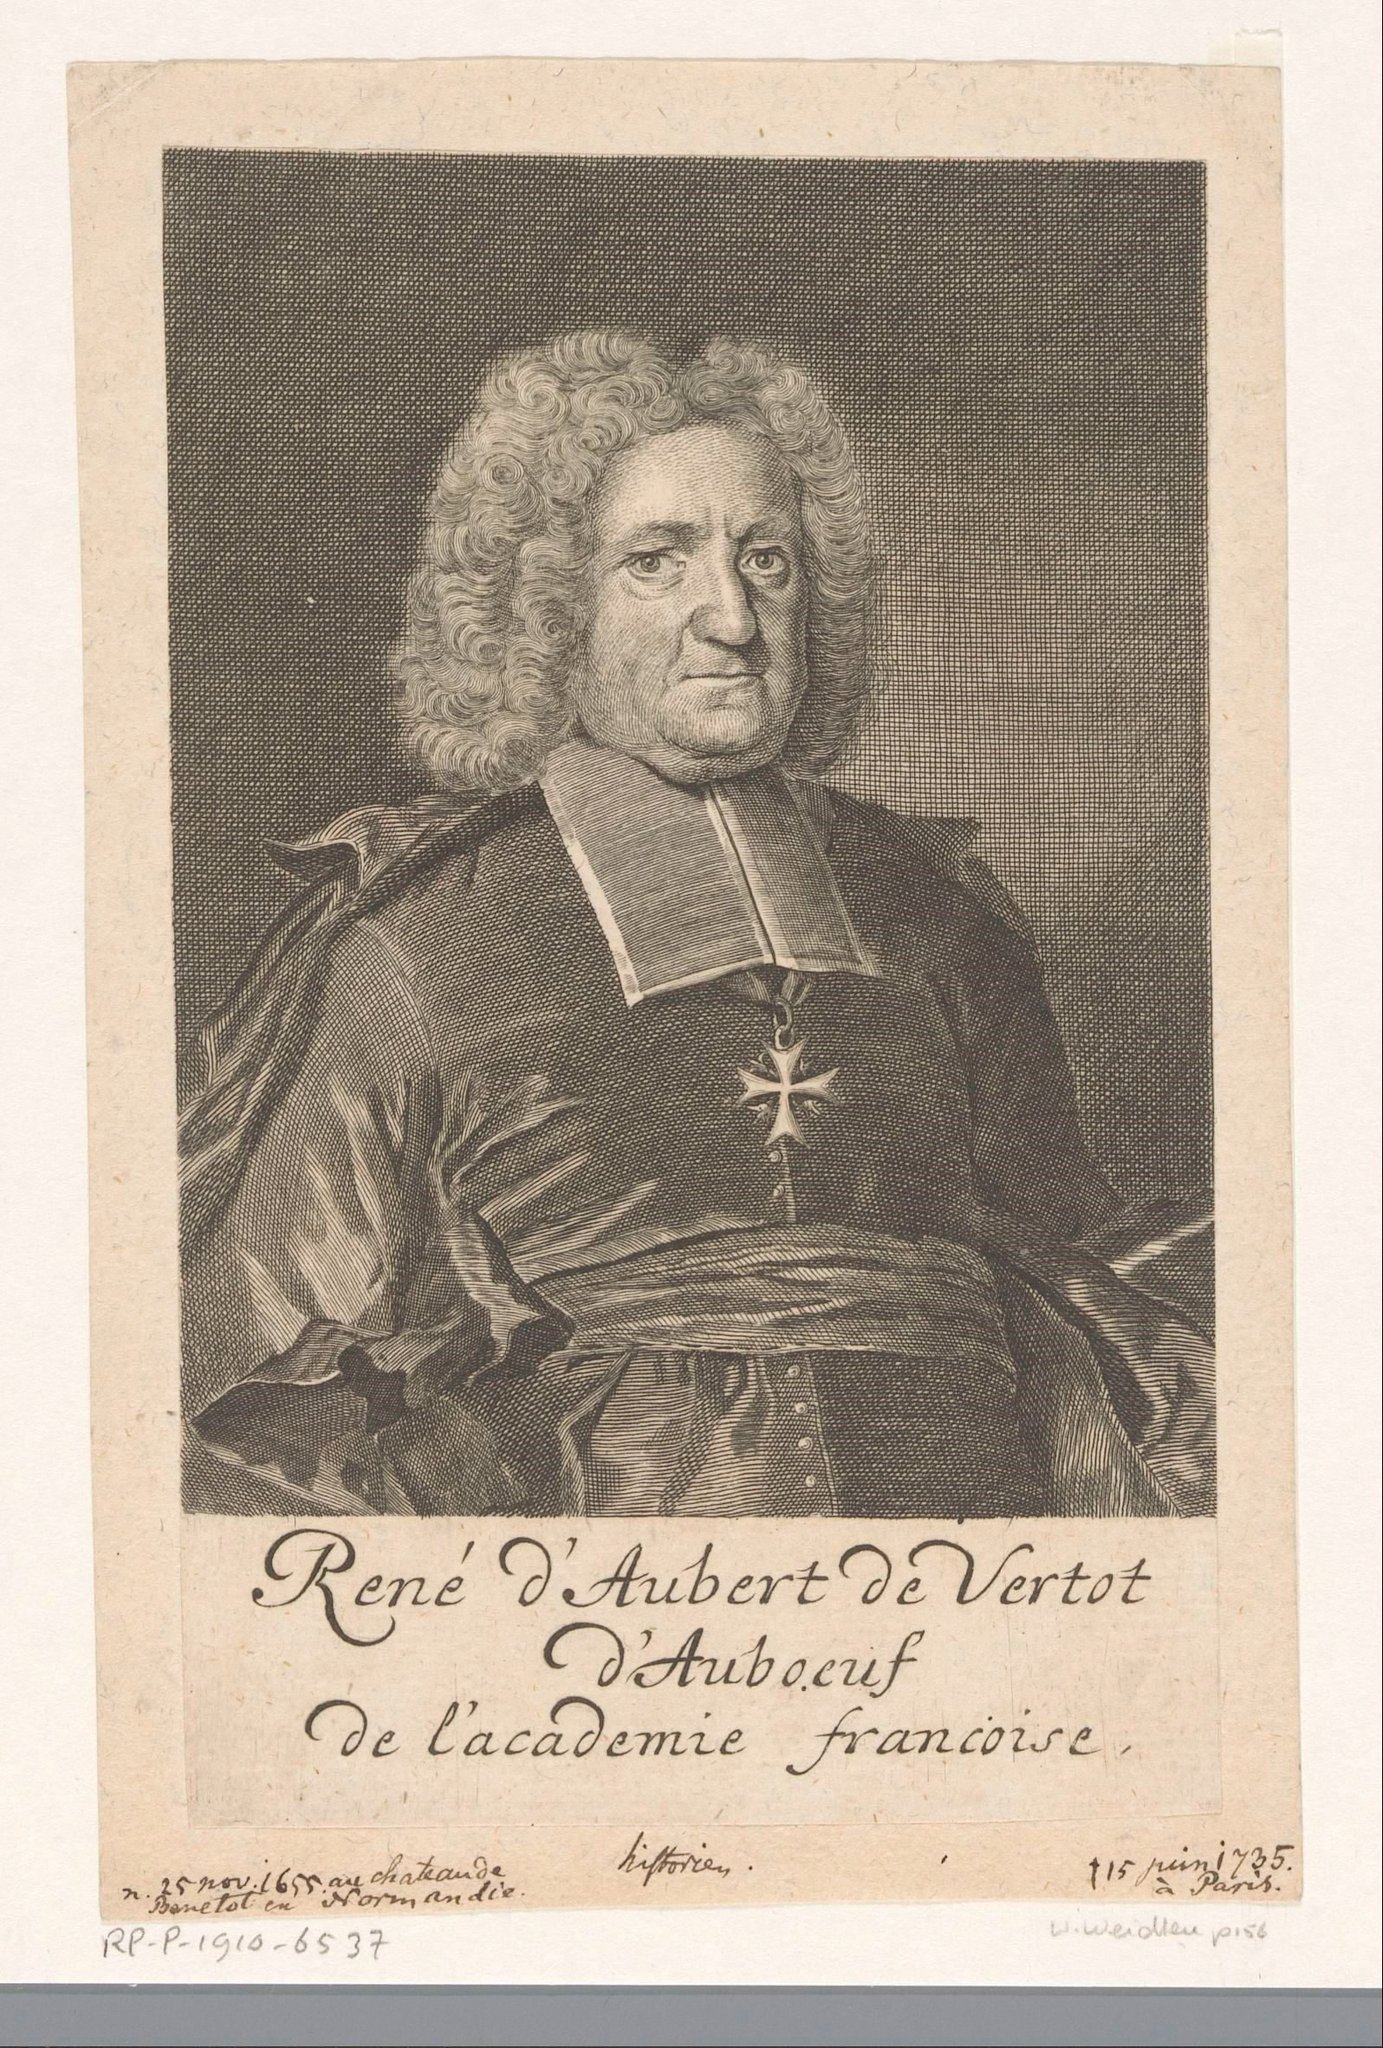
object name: print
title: Portret van René Aubert de Vertot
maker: martin bernigeroth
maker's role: print maker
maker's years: 1670-1733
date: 1727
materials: paper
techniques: engraving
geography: leipzig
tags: priest, historical persons, military orders, e.g.: knights templars, knights of malta, teutonic knights ~ roman catholic church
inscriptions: collector's mark: Lugt 2228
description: Prent ook gebruikt in: Deutsche Acta Eruditorum (...). dl. 125. Leipzig: Johann Gottlieb Gleditsch, 1727.